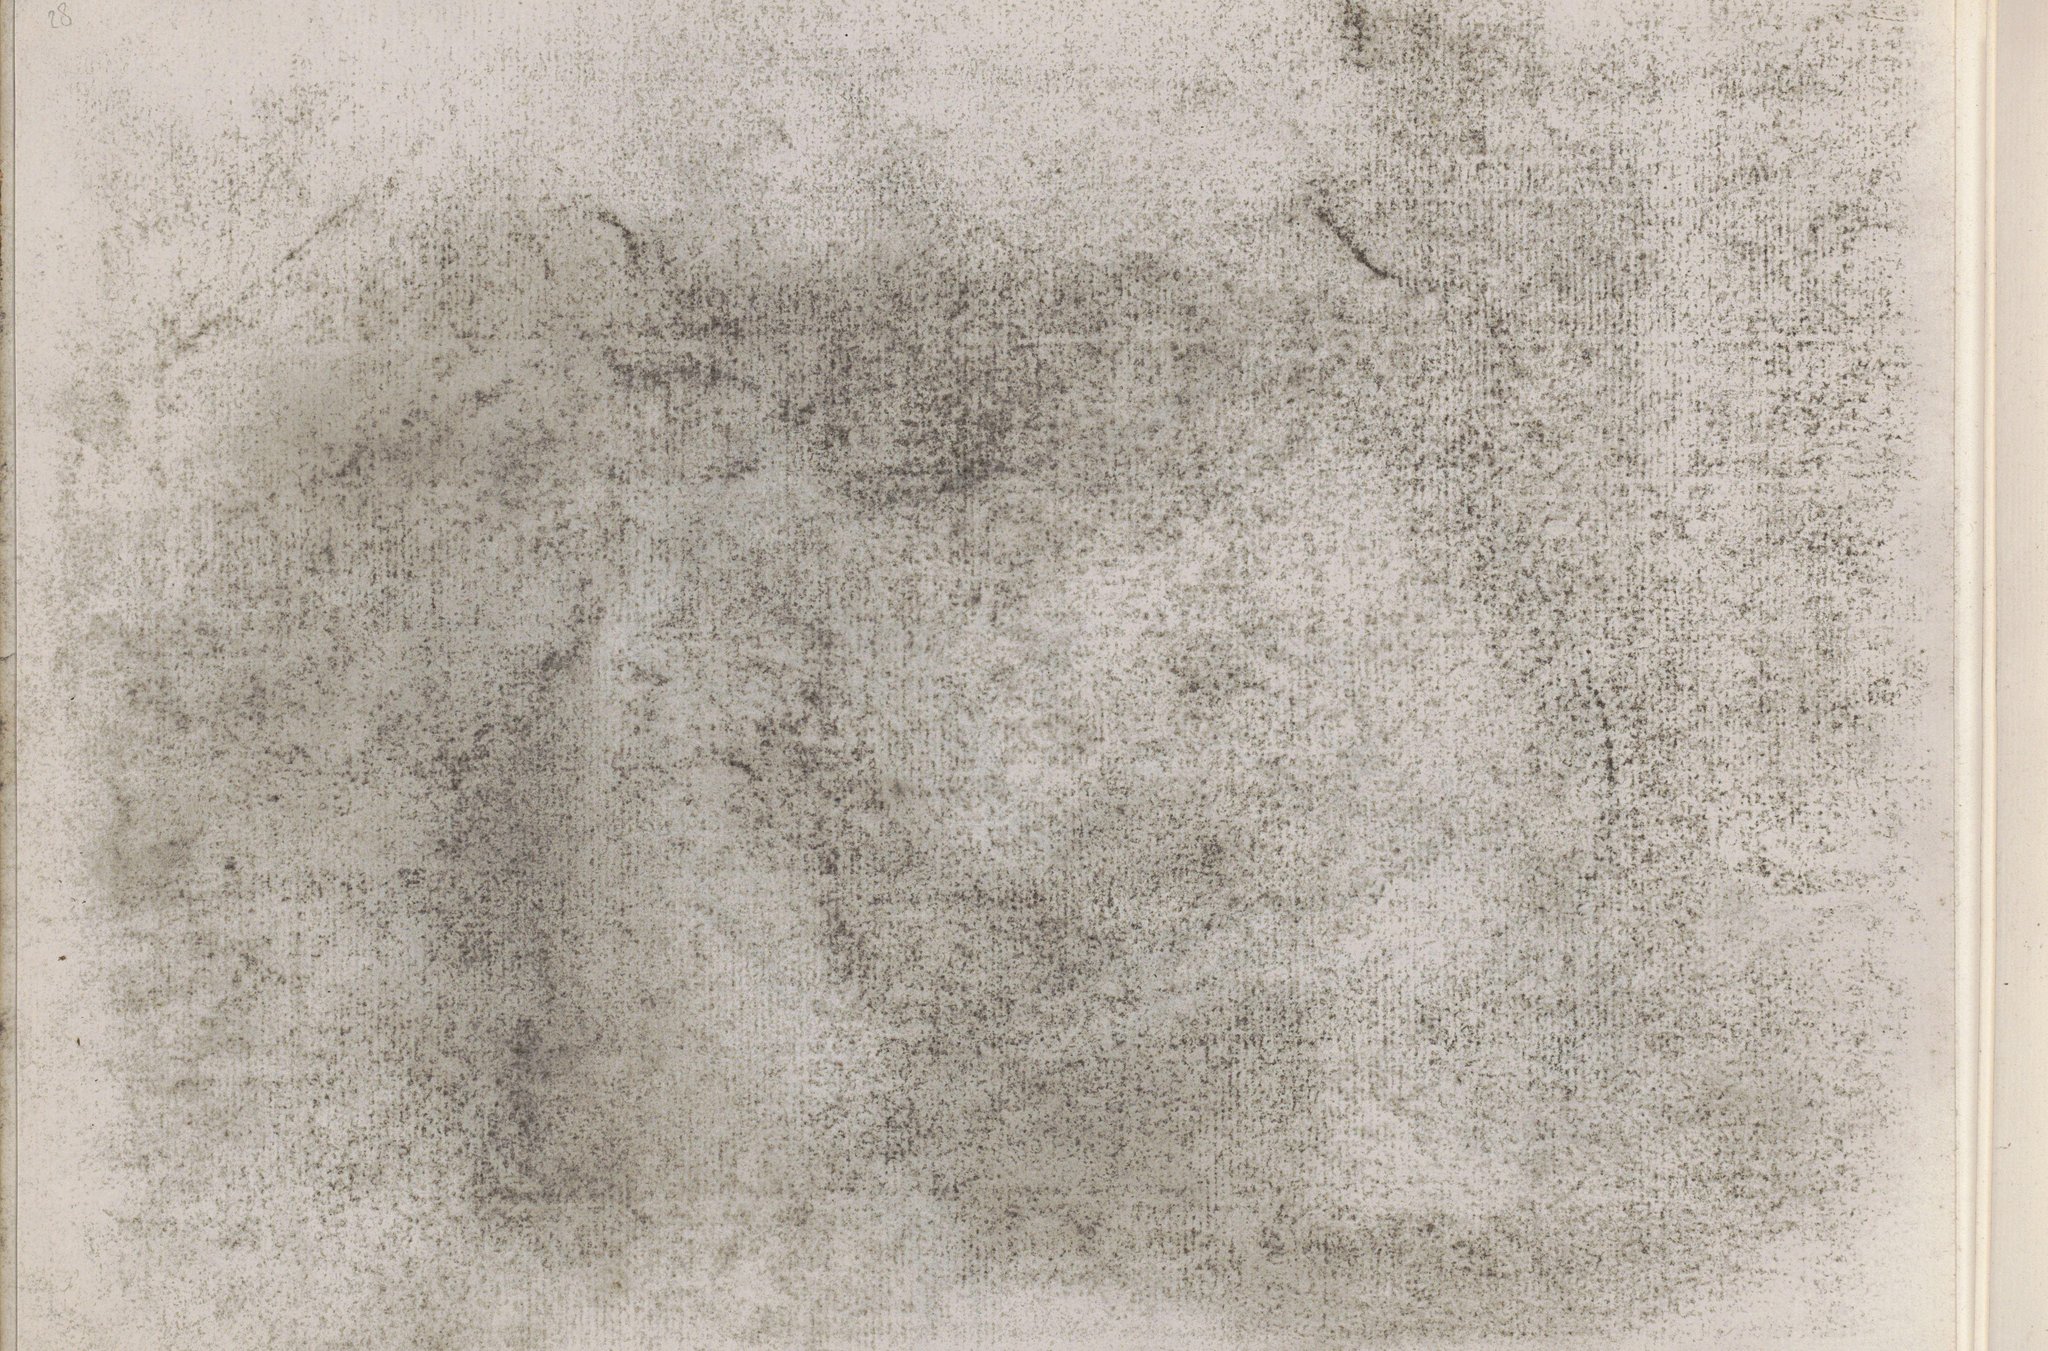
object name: sketchbook leaf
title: Abklatsch van de krijttekening op pagina 29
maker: willem witsen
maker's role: draughtsman, painter, print maker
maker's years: 1860-1923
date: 1887-1892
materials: paper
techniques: printmaking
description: Pagina 28 uit een schetsboek met 17 bladen.